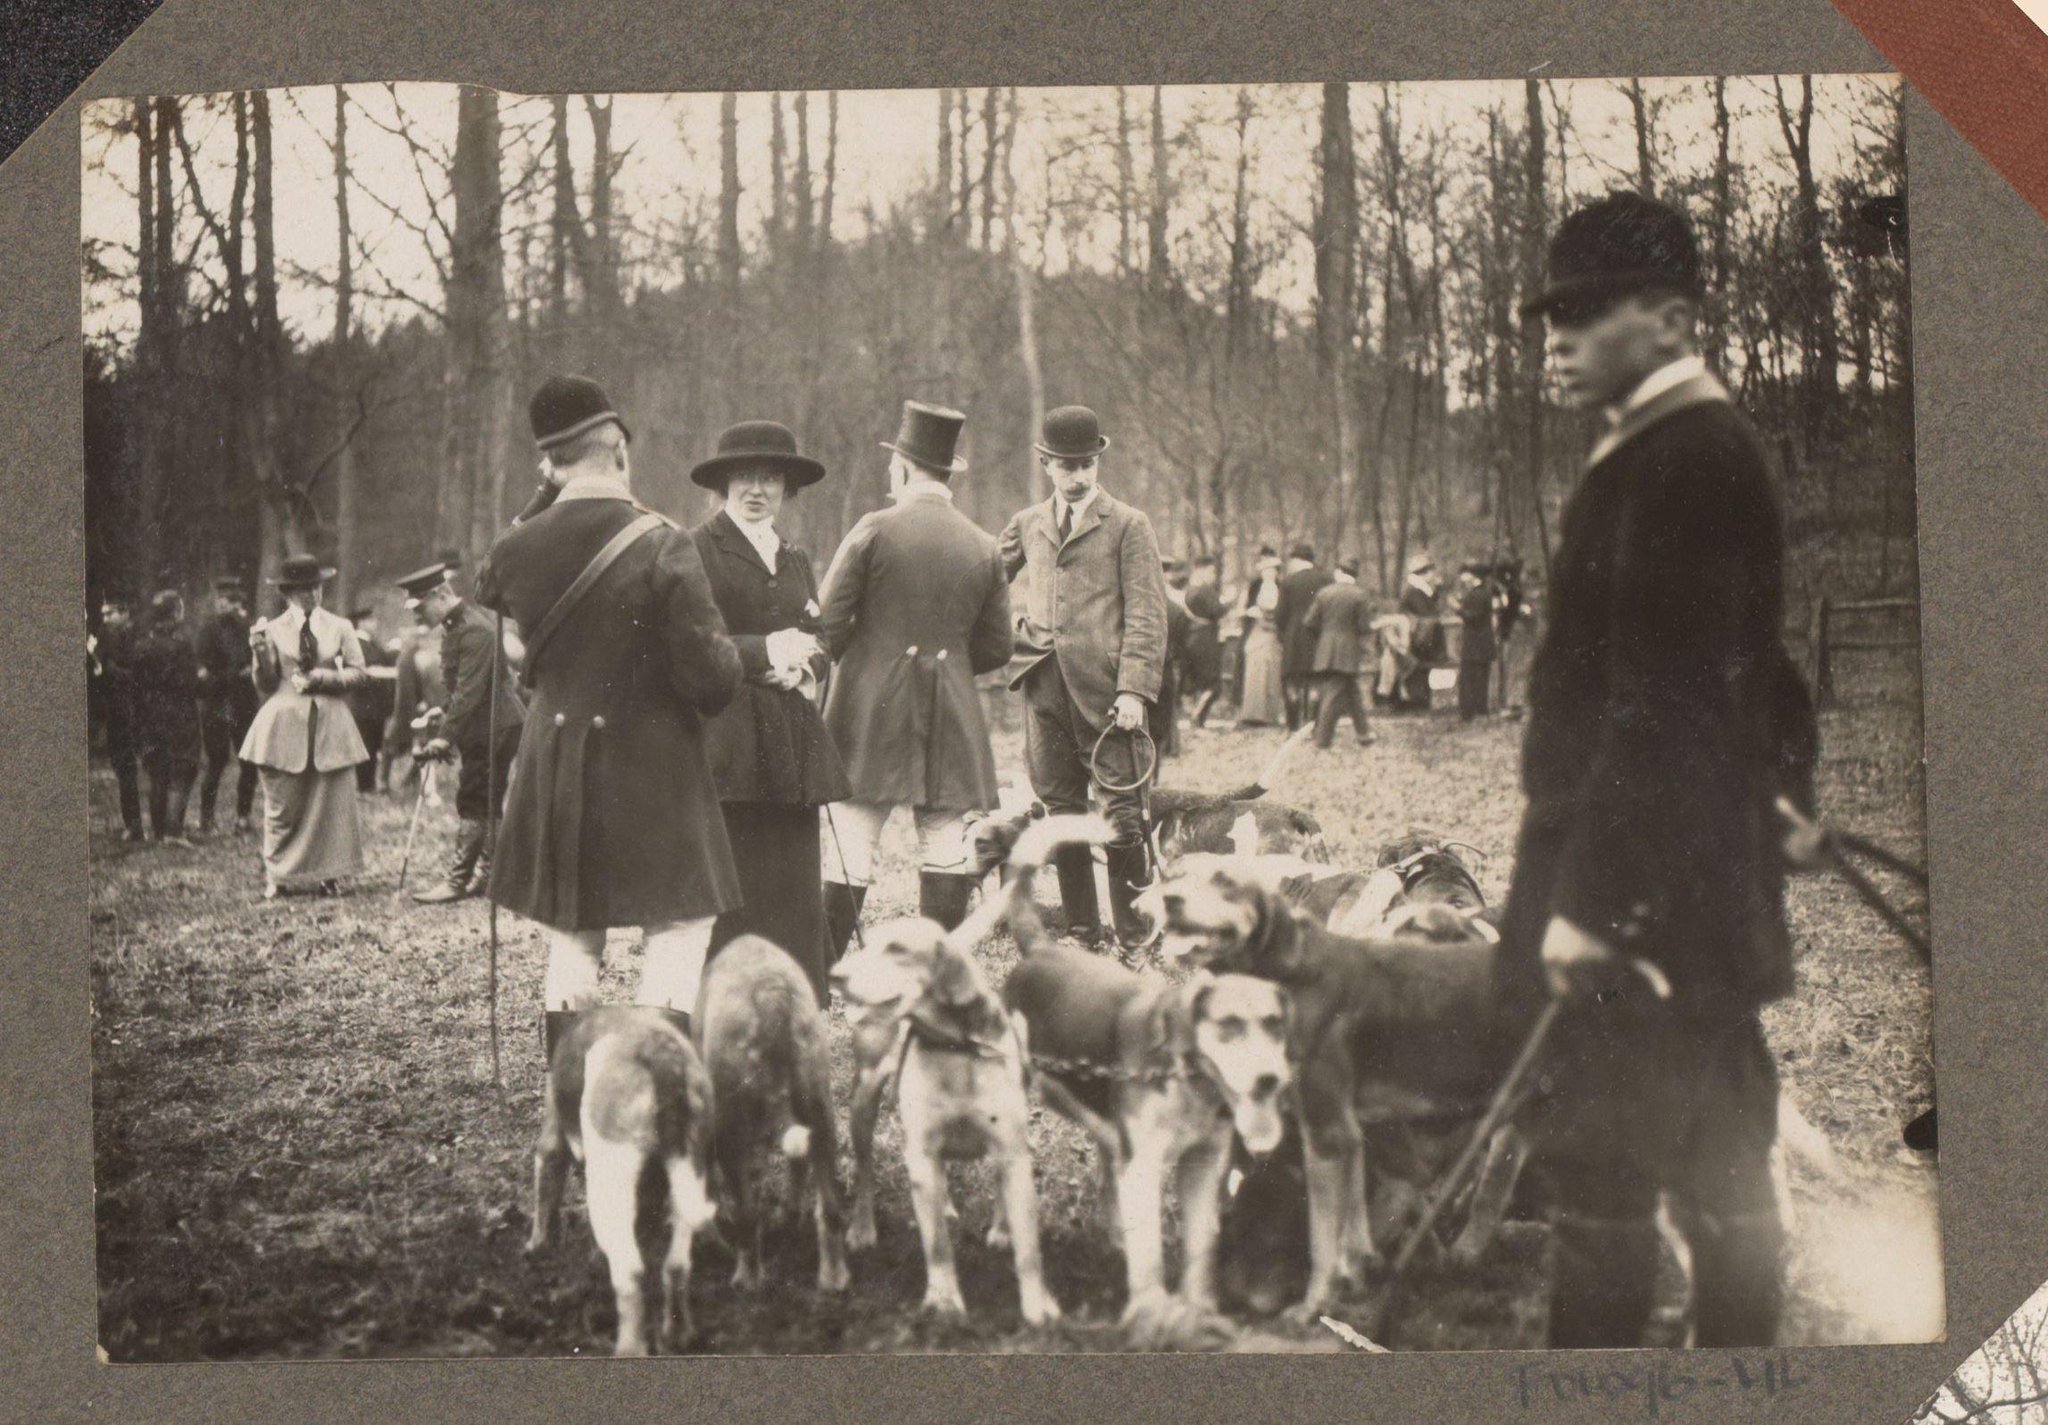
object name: photograph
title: Ruitertafereel op Koninklijke Houtvesterij Het Loo: ruiters en publiek met een meute honden in een bos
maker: Anonymous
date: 1900-1925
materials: photographic support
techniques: gelatin silver print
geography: het loo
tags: riding a horse, ass, or mule; rider, horseman, hunting, chase, hunting dogs, hunting-ground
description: Onderdeel van Fotoalbum van de heer Brams, opperhoutvester van koningin Wilhelmina op Koninklijke Houtvesterij Het Loo.